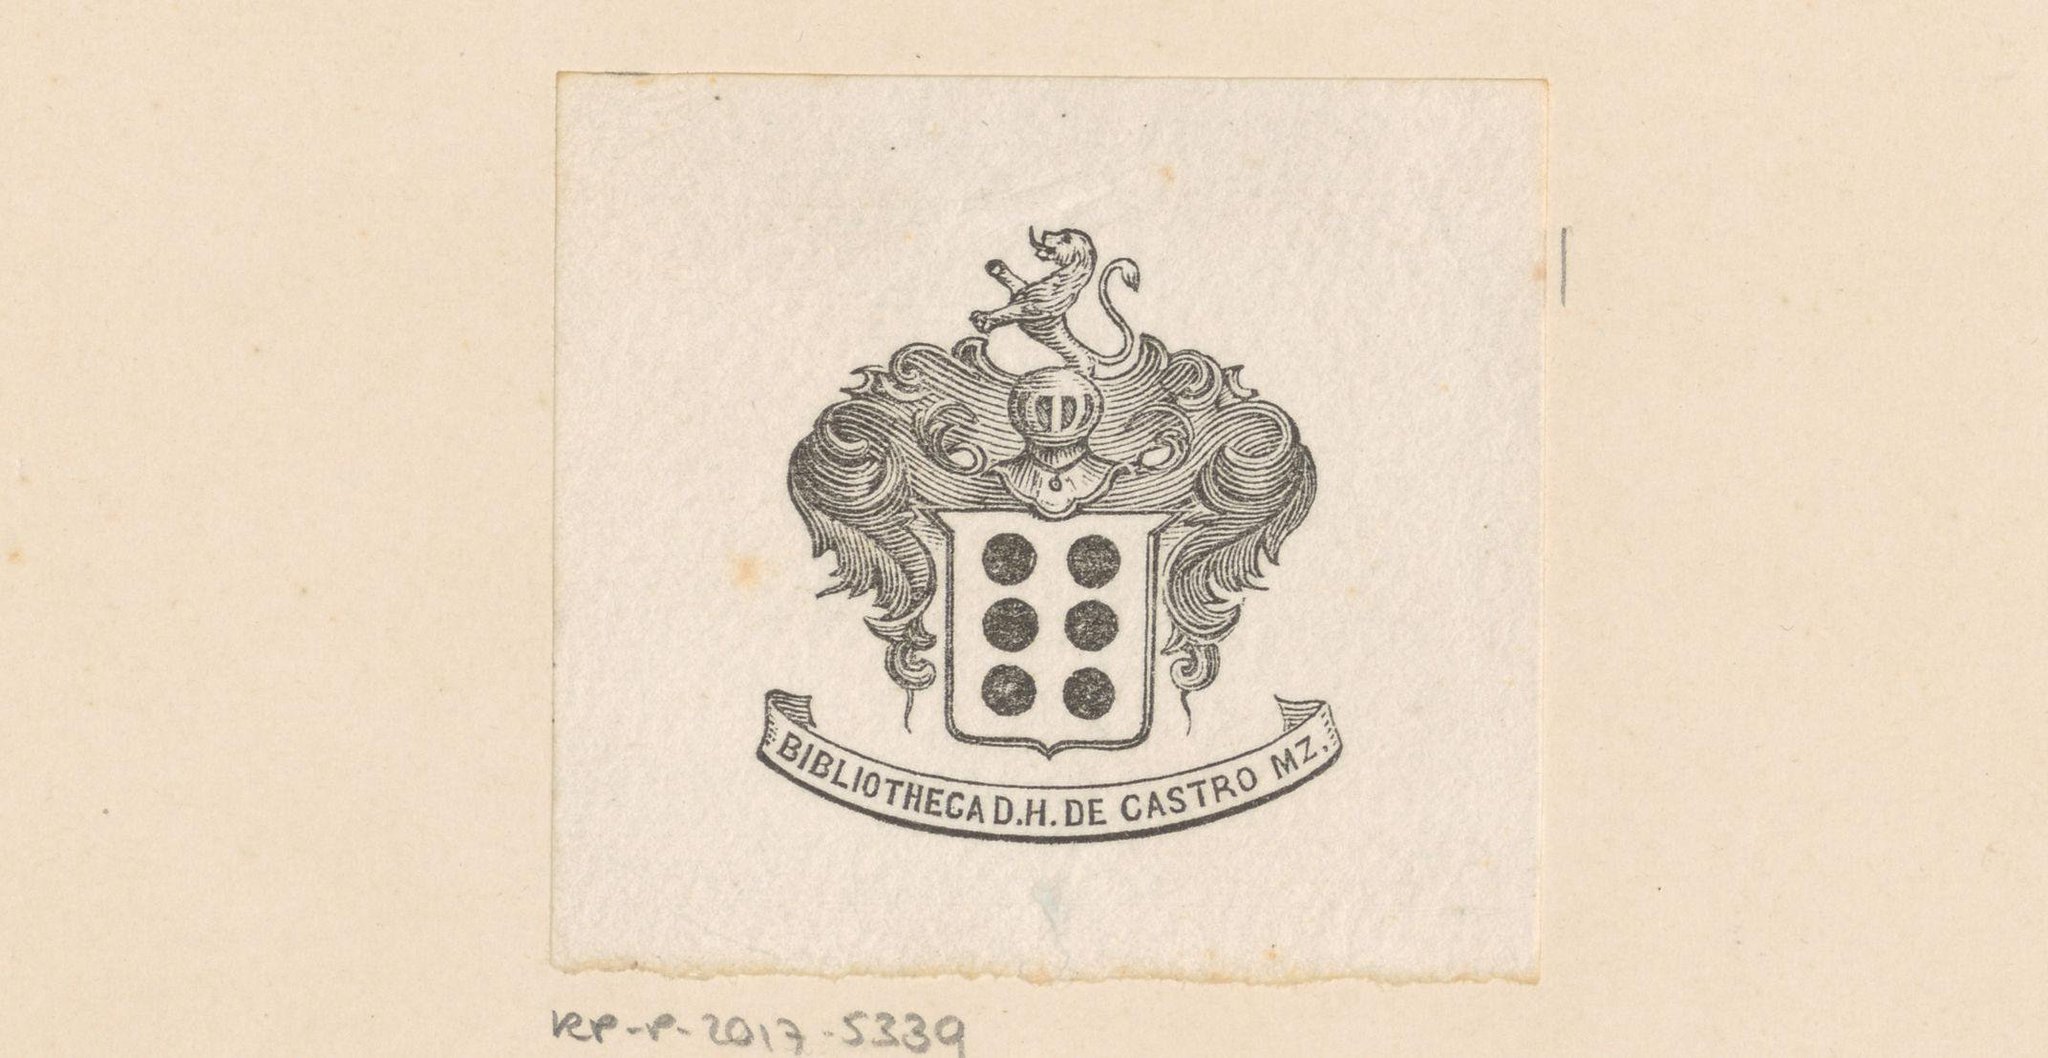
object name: bookplate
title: Ex libris van D.H. de Castro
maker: Anonymous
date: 1836-1898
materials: paper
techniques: printing block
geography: netherlands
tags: armorial bearing, heraldry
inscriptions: inscription: ‘Rietstap, 386.’